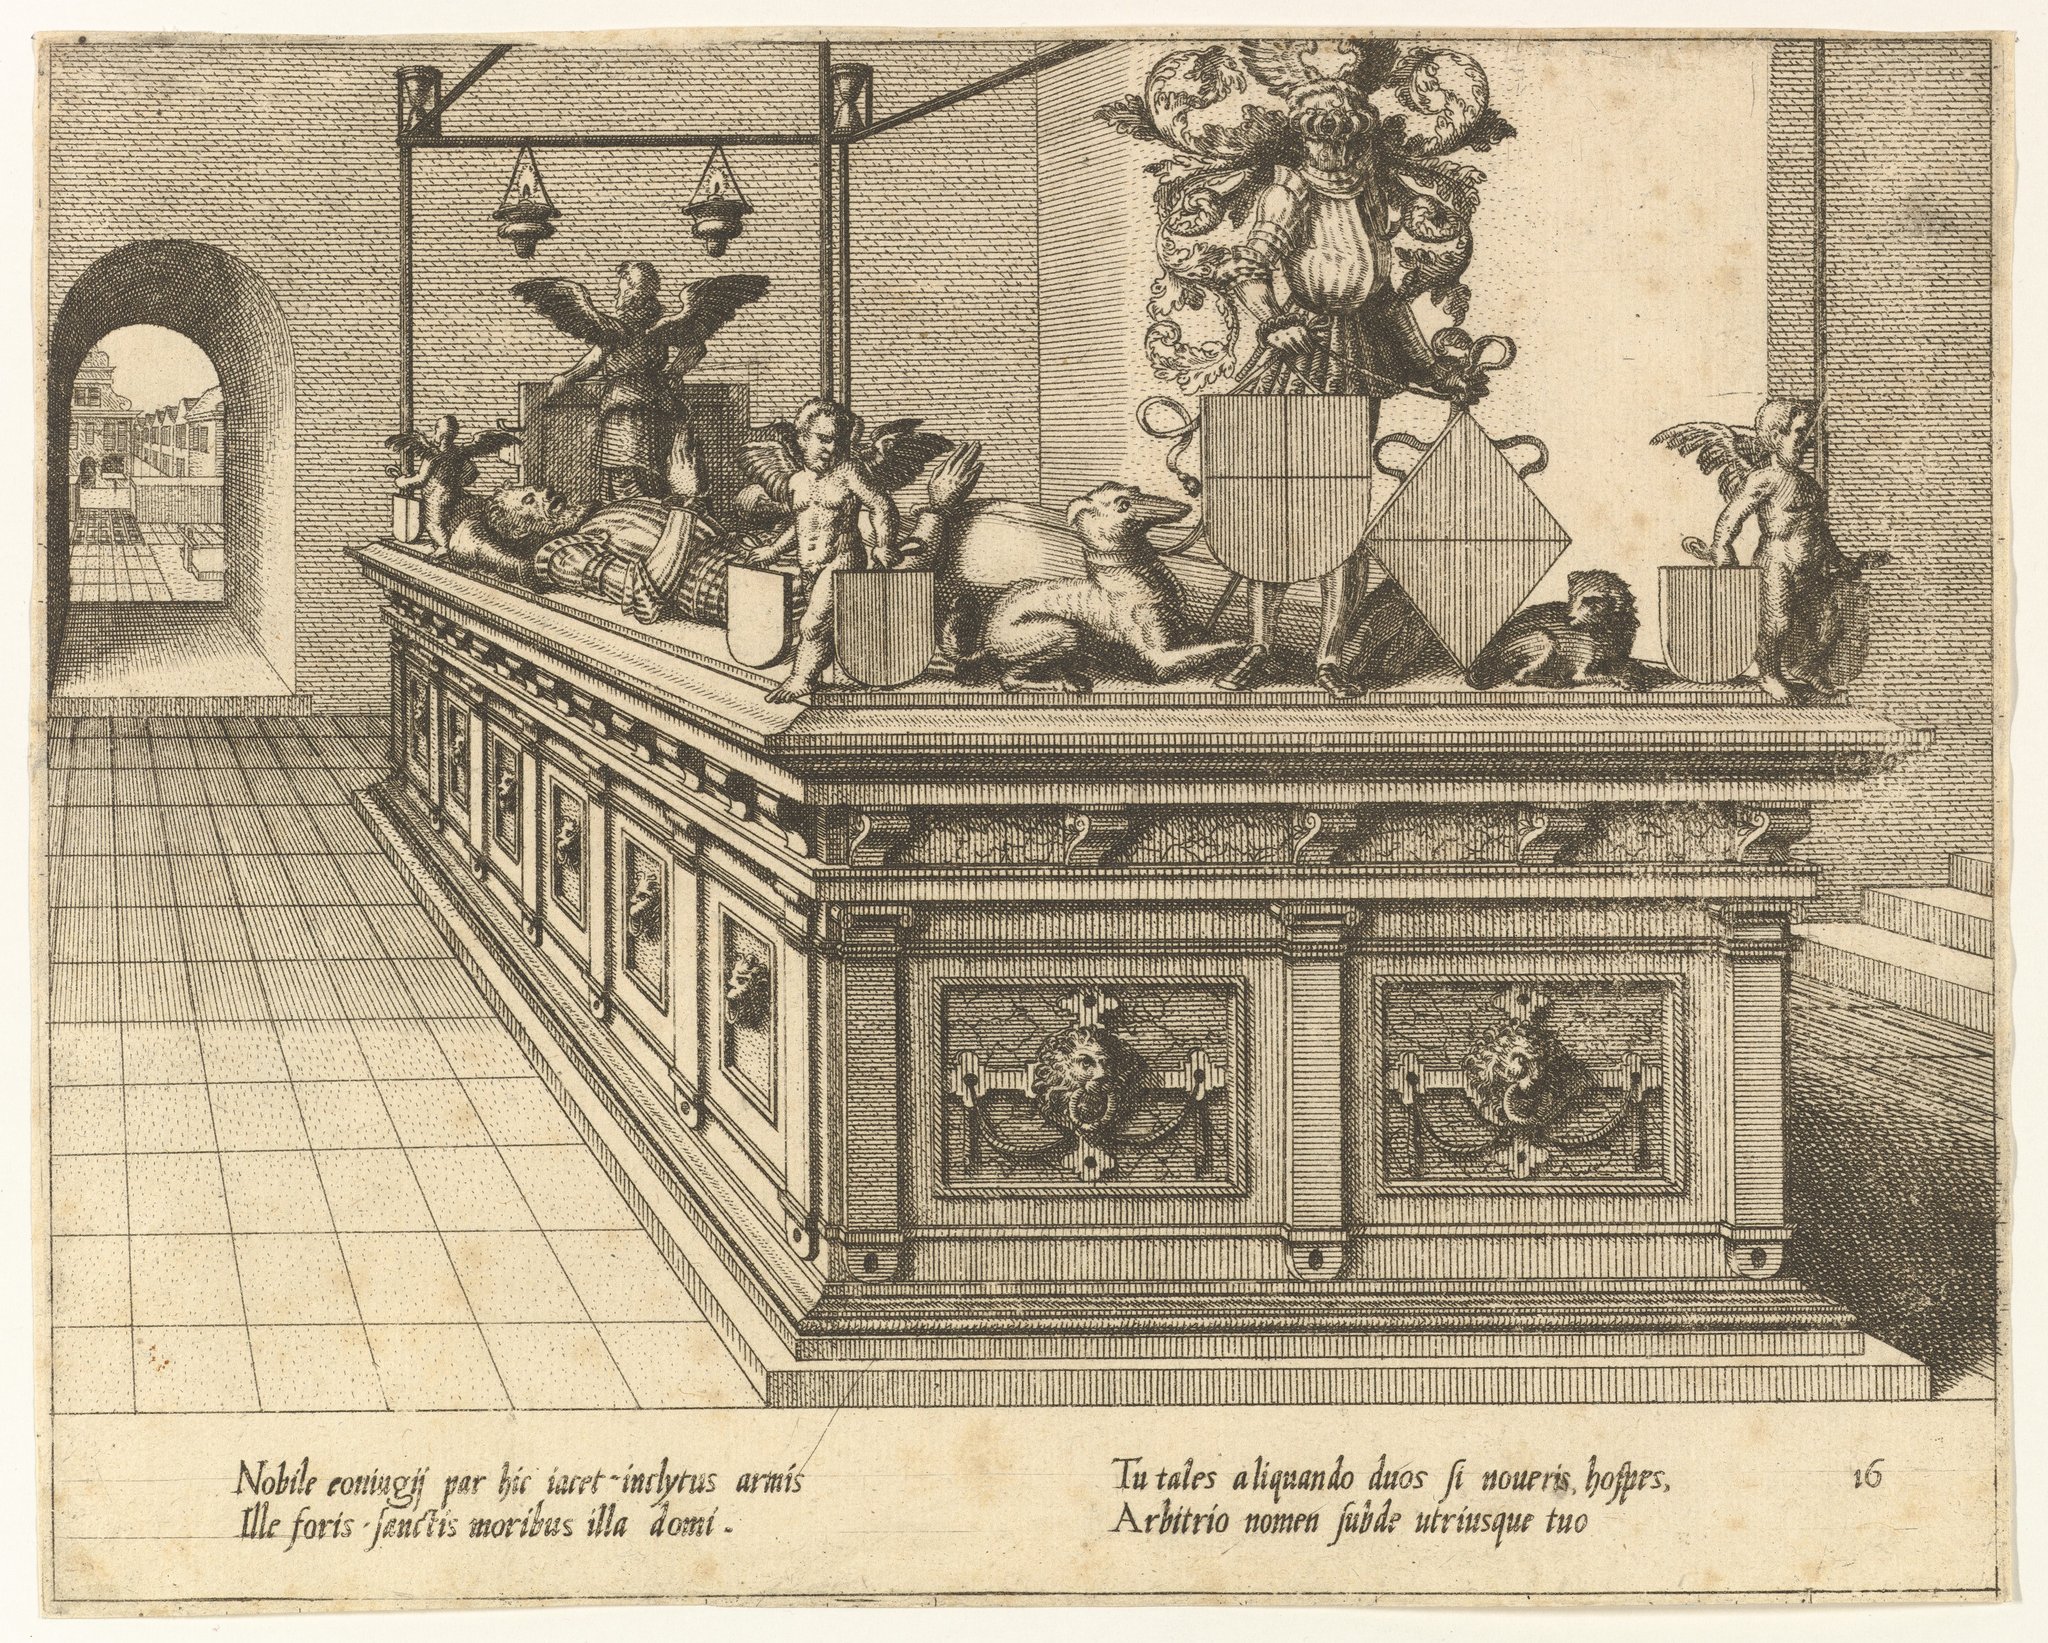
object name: collection ornament architecture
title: Cœnotaphiorum (16)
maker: hans vredeman de vries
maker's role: artist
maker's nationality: netherlandish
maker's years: 1527-1606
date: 1563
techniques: etching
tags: men,women,coat of arms